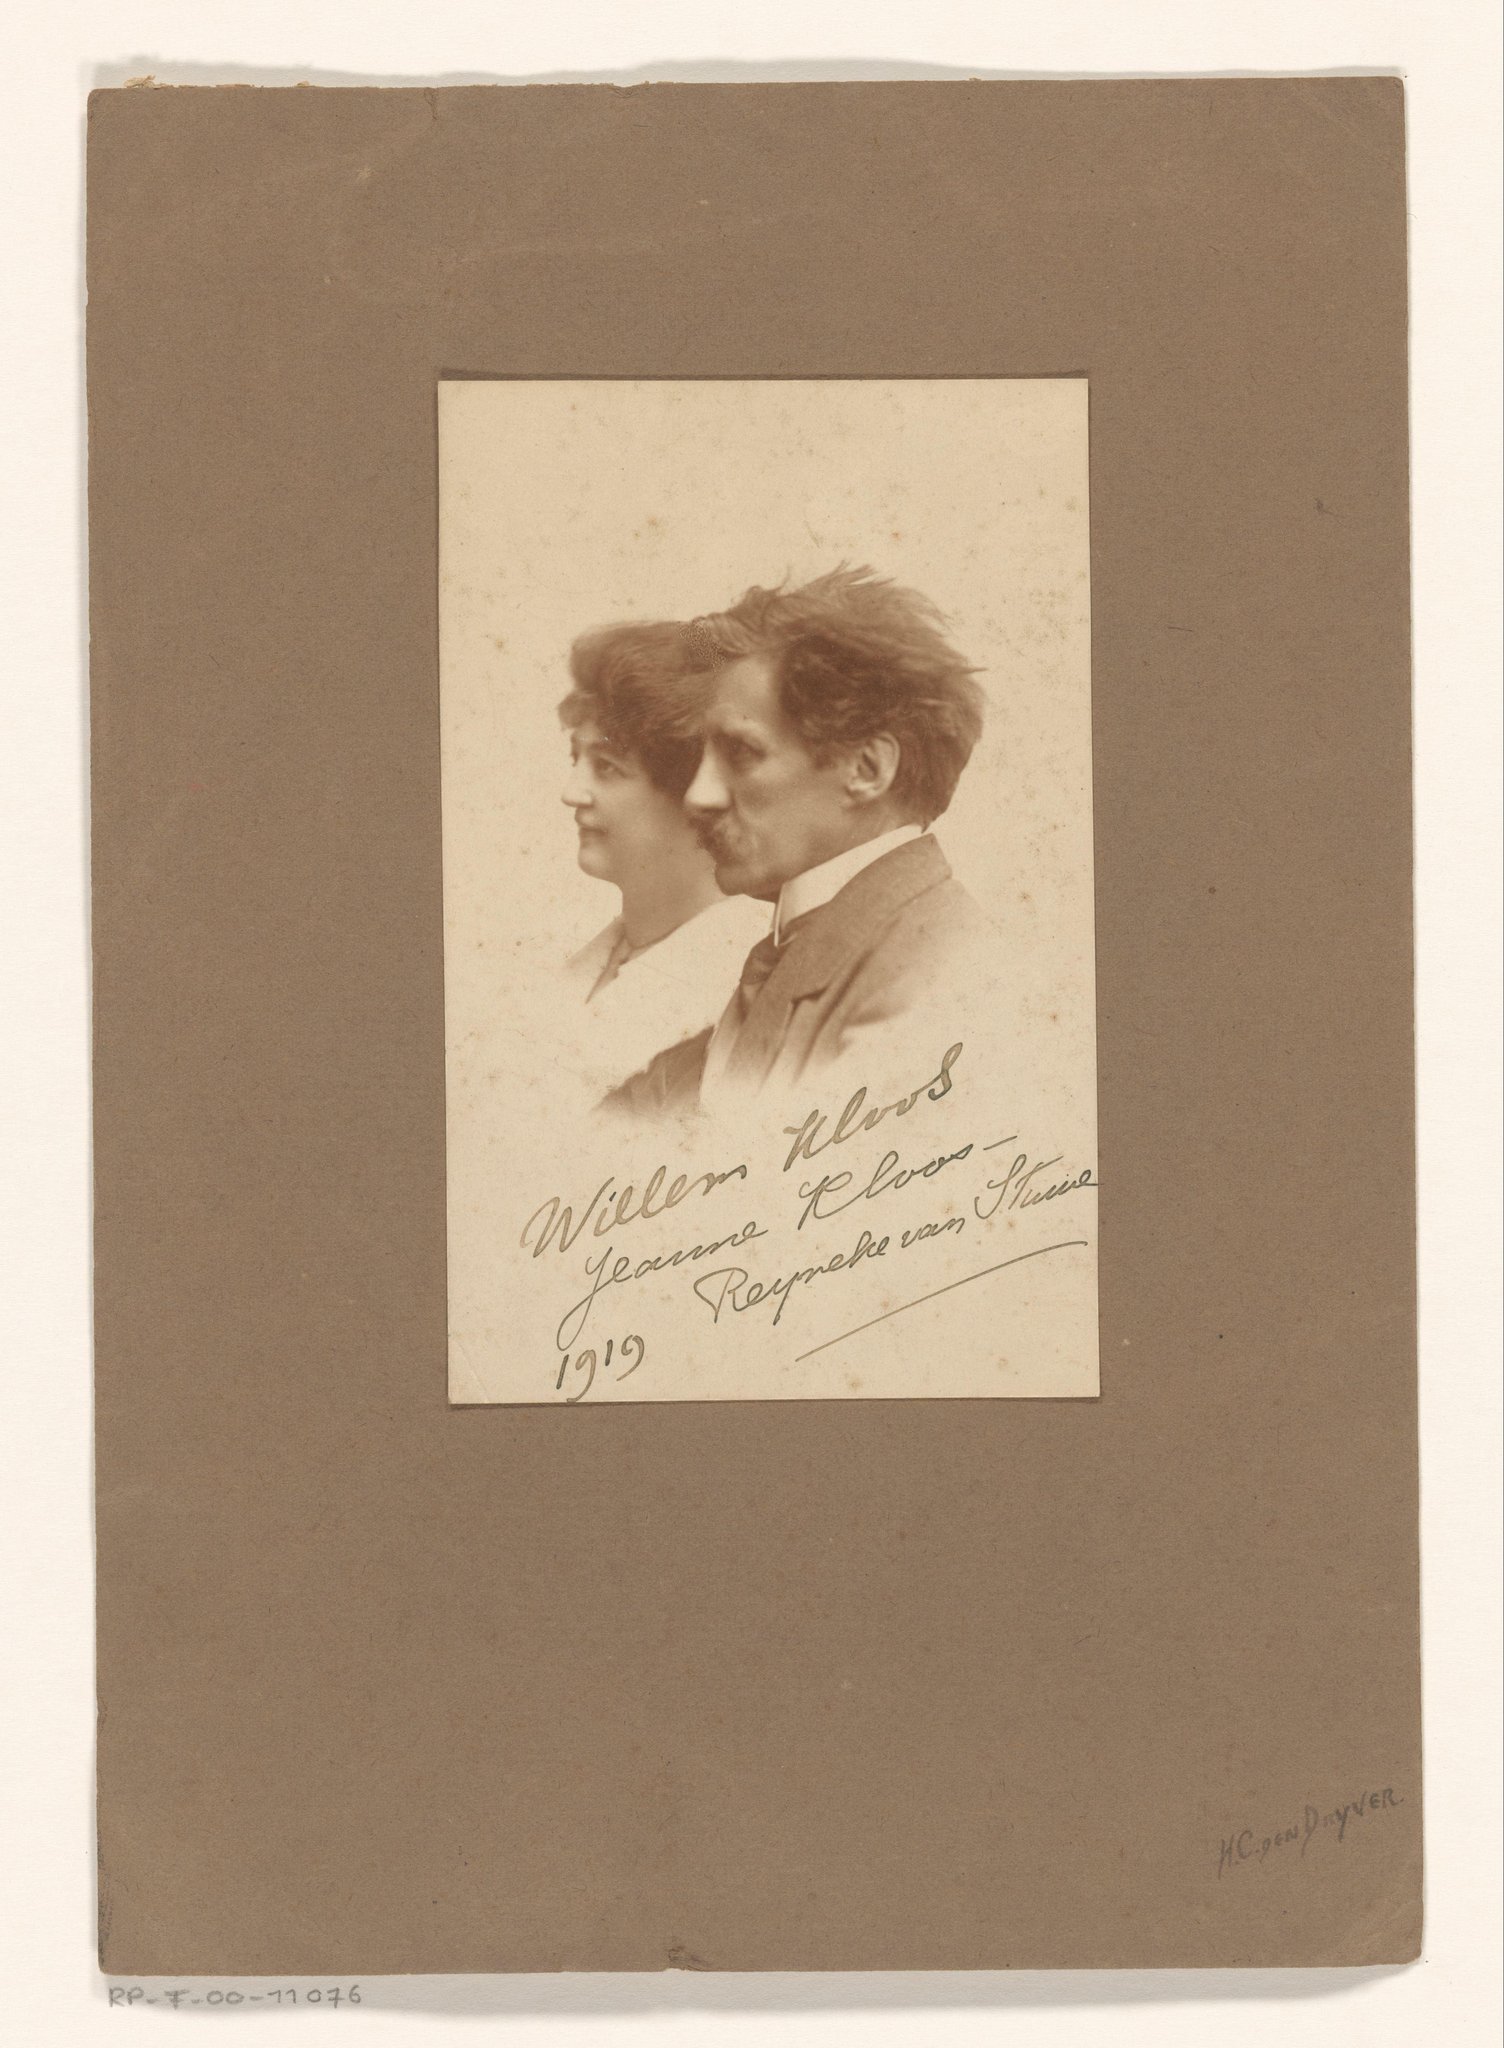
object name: photograph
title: Portret van Jeanne Henriette Reine Reyneke van Stuwe en Willem Kloos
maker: hendrik cornelis den drijver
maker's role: fotograaf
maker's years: 1880-1969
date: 1919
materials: cardboard, photographic support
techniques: matte daylight collodion silver print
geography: the hague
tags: amsterdam, the hague, willem kloos, jeanne henriette reine reyneke van stuwe, writer, poet, author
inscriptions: collector's mark: Lugt 2228a, inscription: ‘H.C. DEN DRYVER.’, name: ‘Willem Kloos/ Jeanne Kloos-/ Reyneke van Stuwe/ 1919’